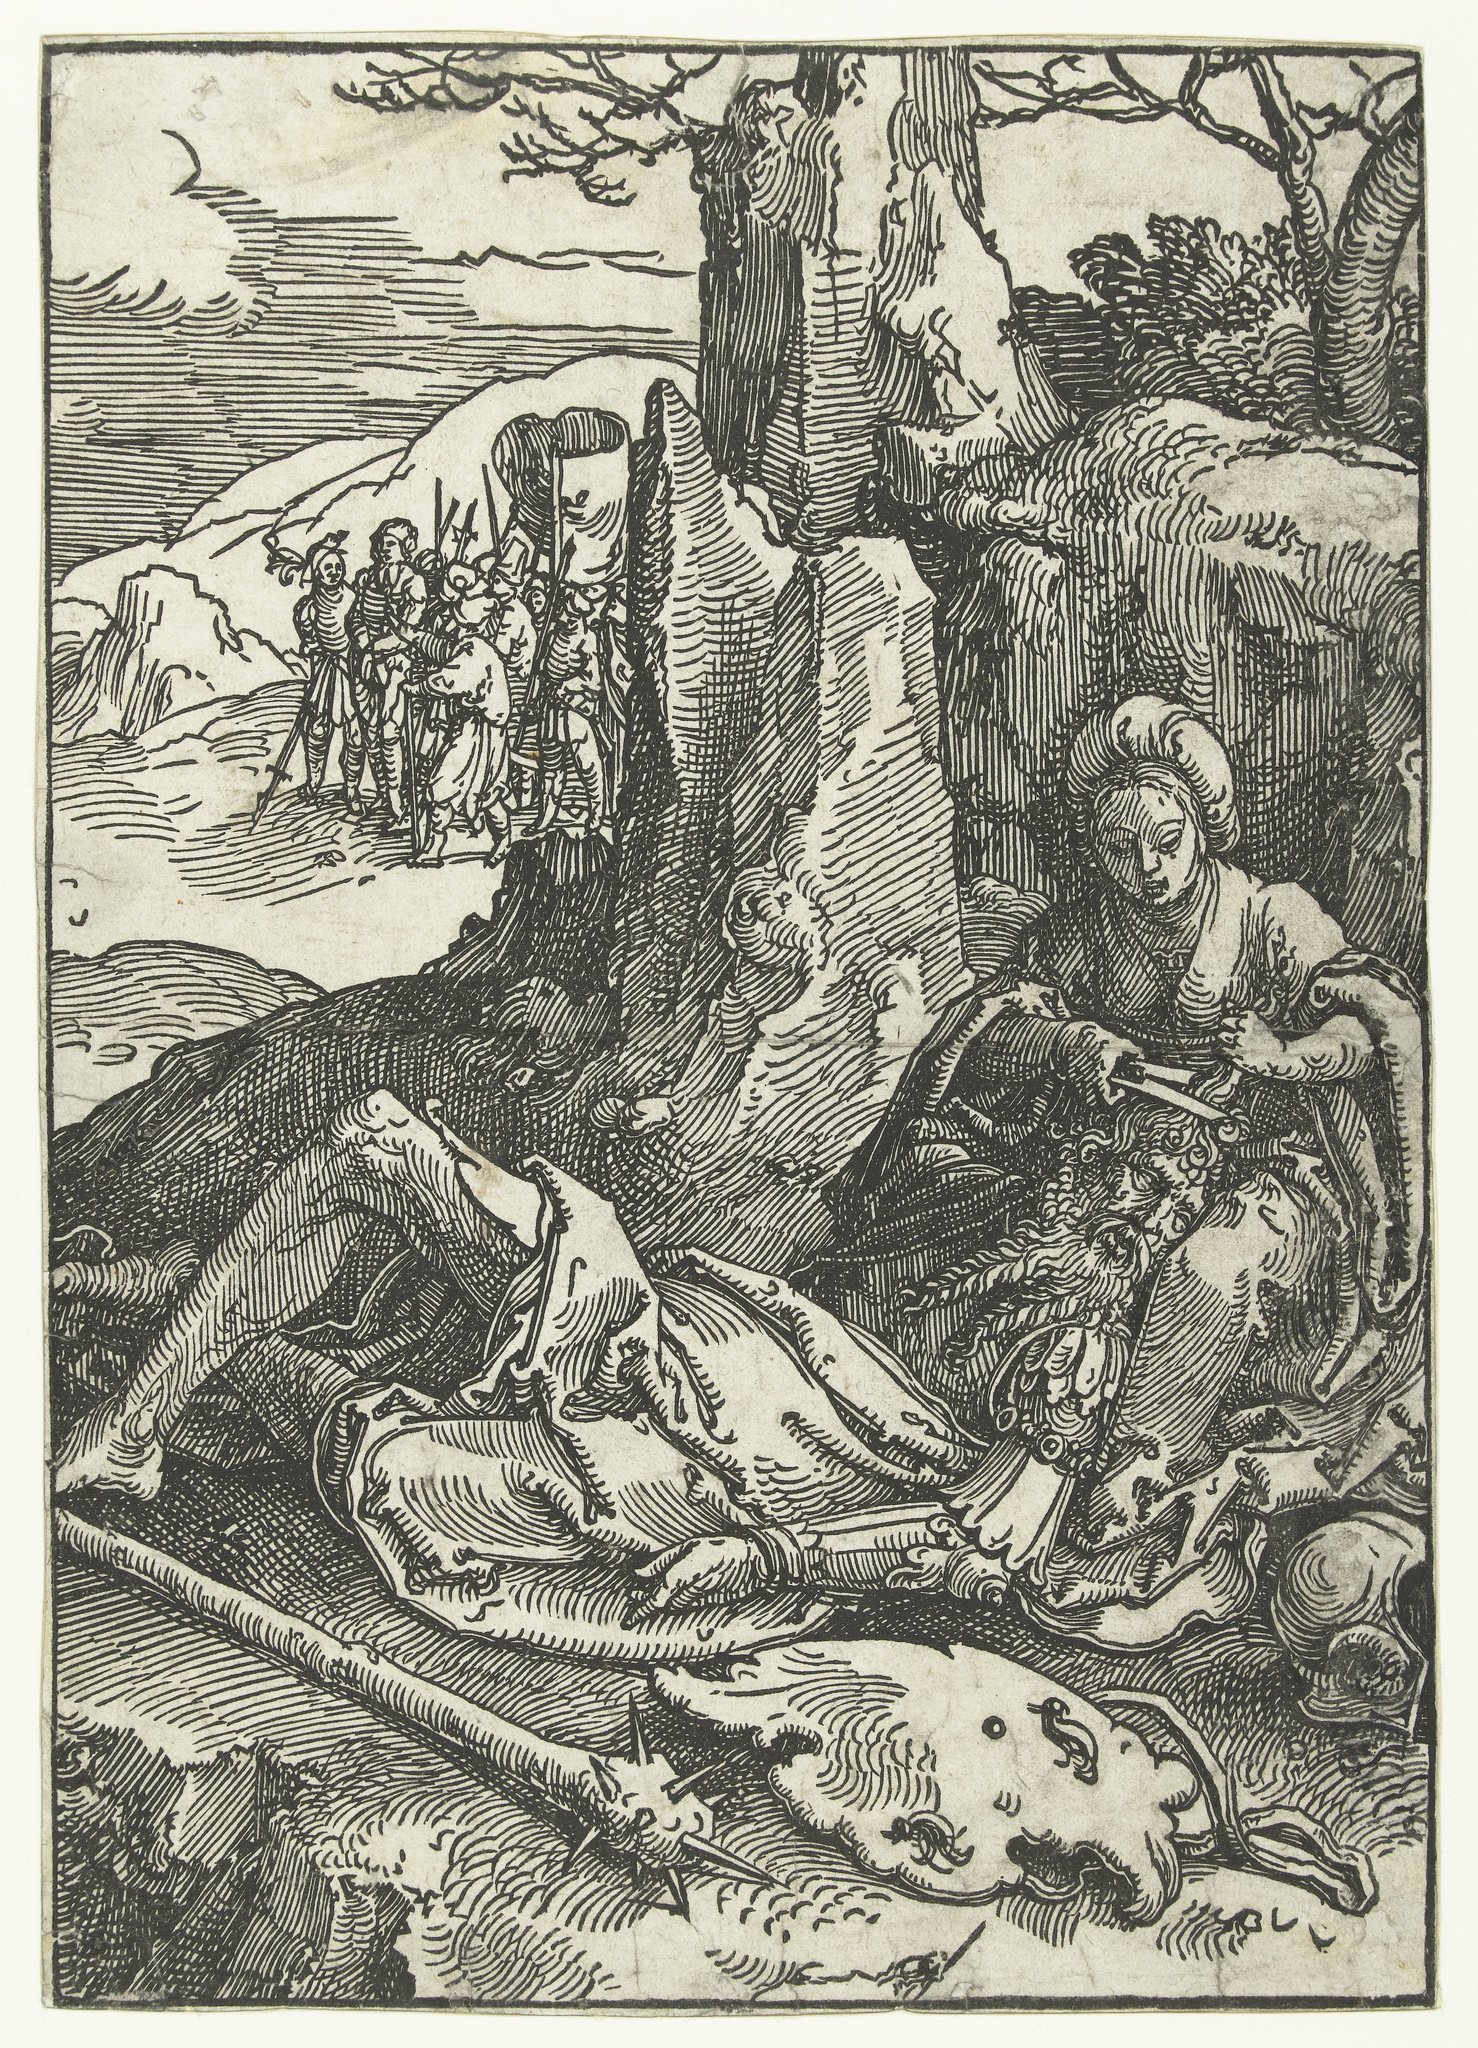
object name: print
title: Kleine serie Vrouwenlisten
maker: lucas van leyden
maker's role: draughtsman, painter, print maker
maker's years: 1494-1533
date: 1515-1519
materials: paper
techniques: woodcut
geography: low countries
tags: samson's hairlocks are cut off by delilah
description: Delila knipt de haren van de slapende Simson.